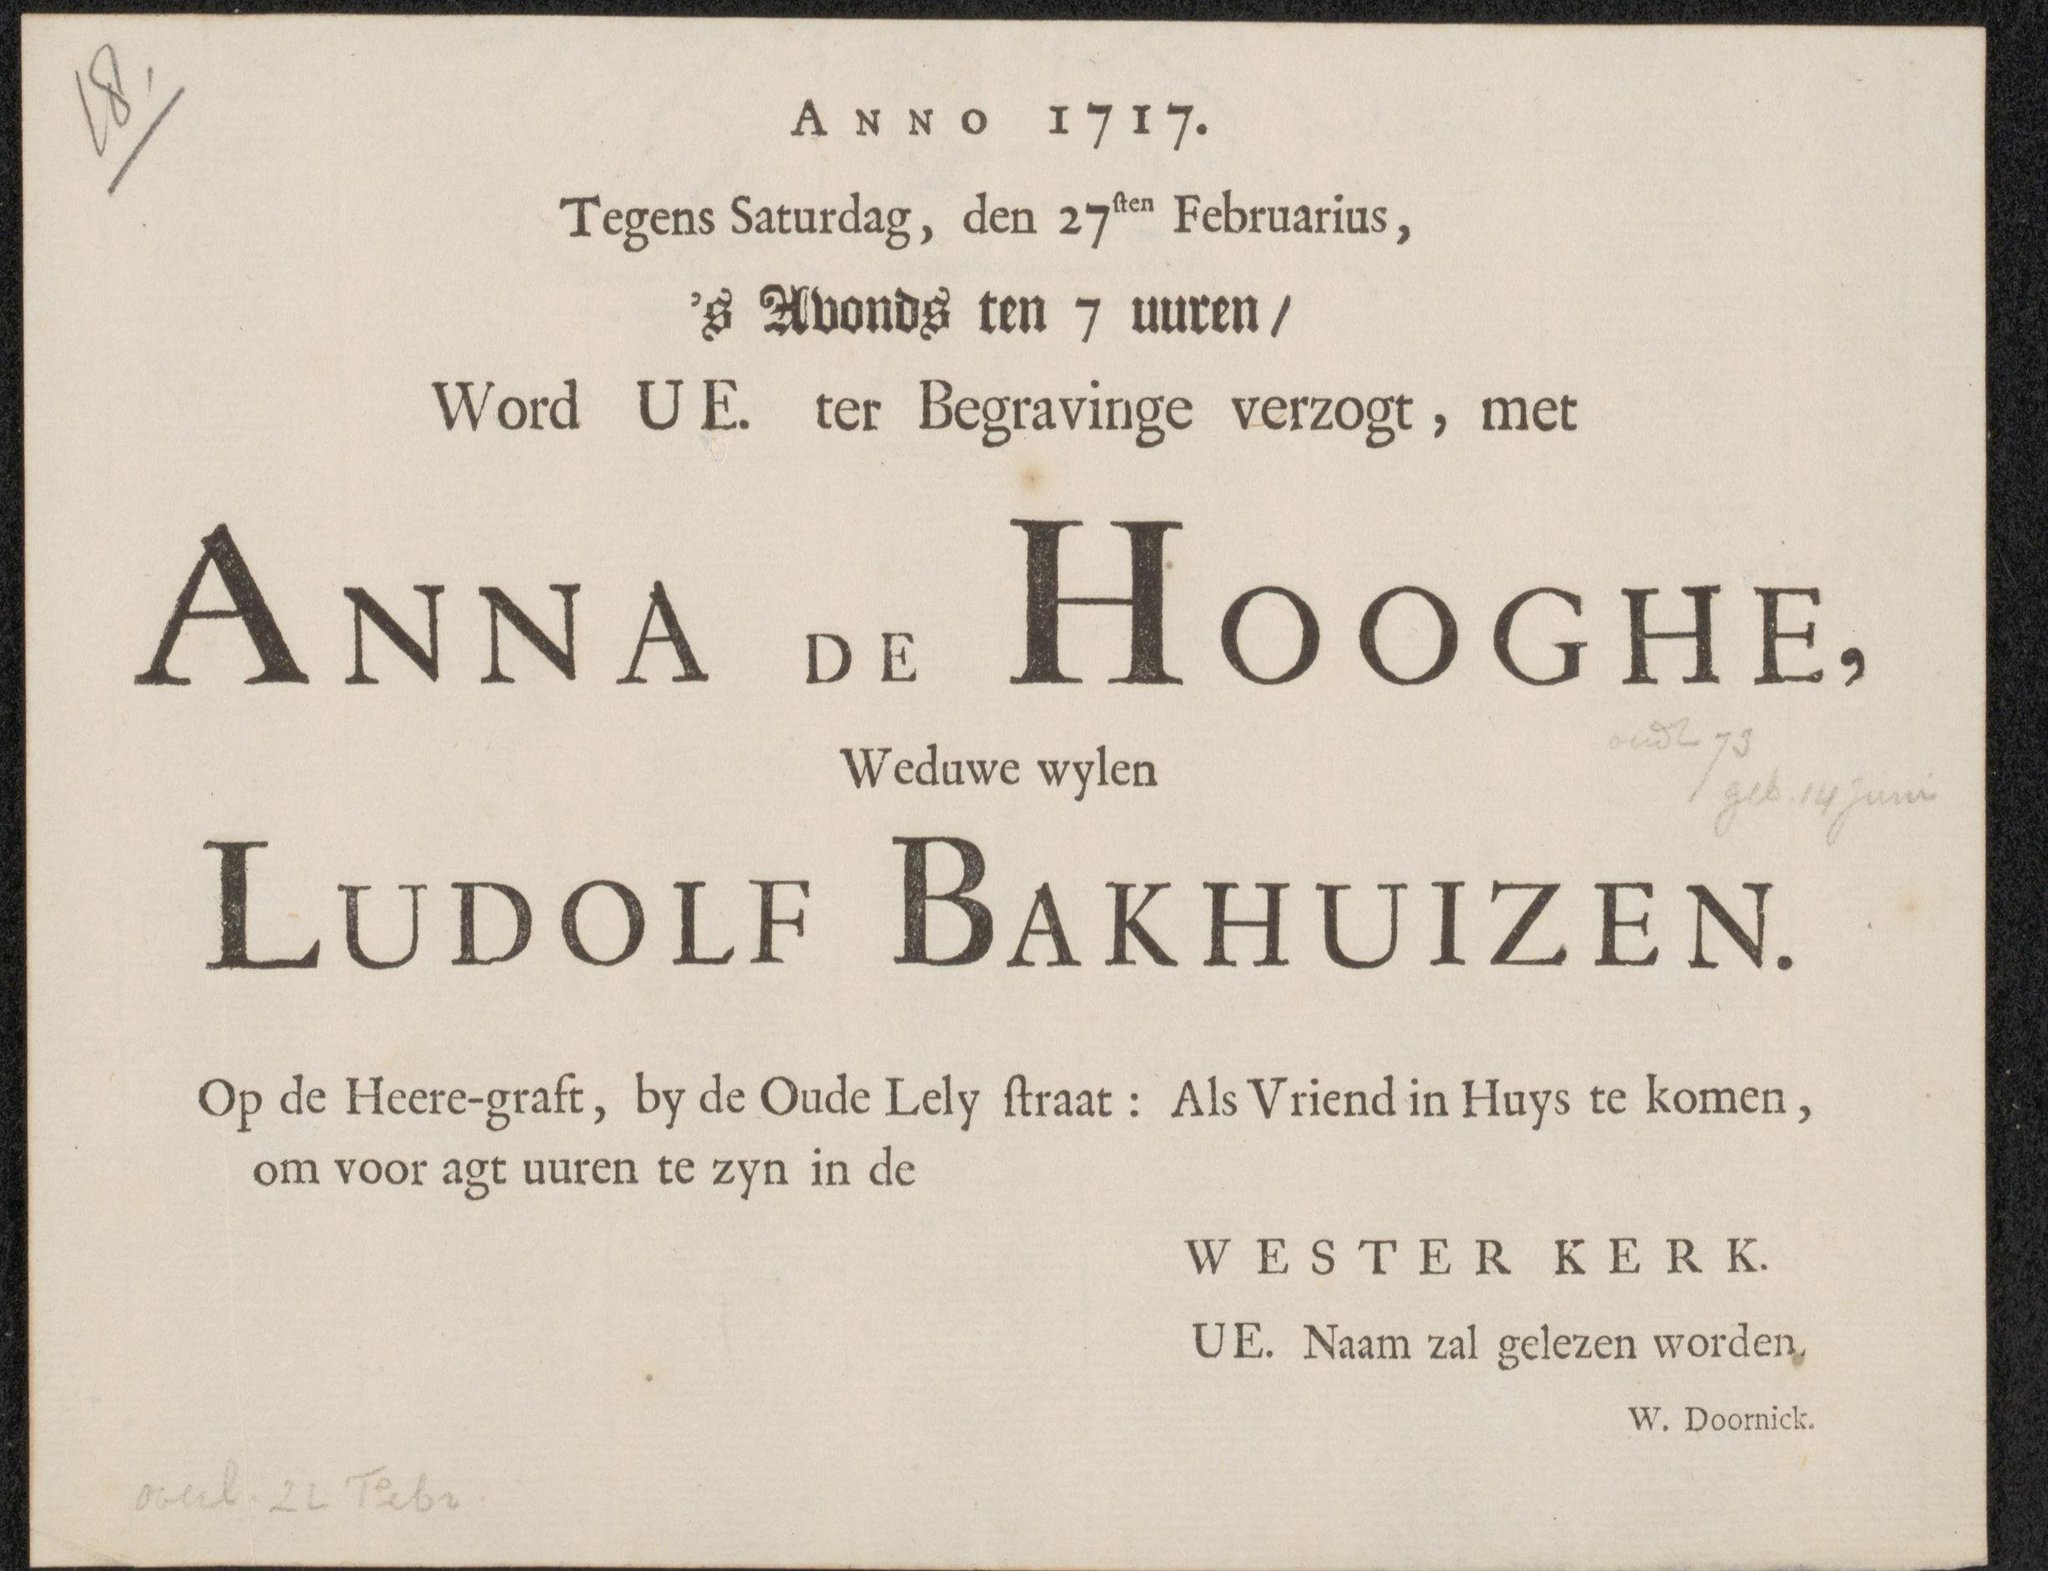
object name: invitation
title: Uitnodiging voor de begrafenis van Anna de Hooghe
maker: w. doornick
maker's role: printer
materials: paper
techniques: printing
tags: anna de hooghe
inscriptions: collector's mark: Lugt 2233, watermark